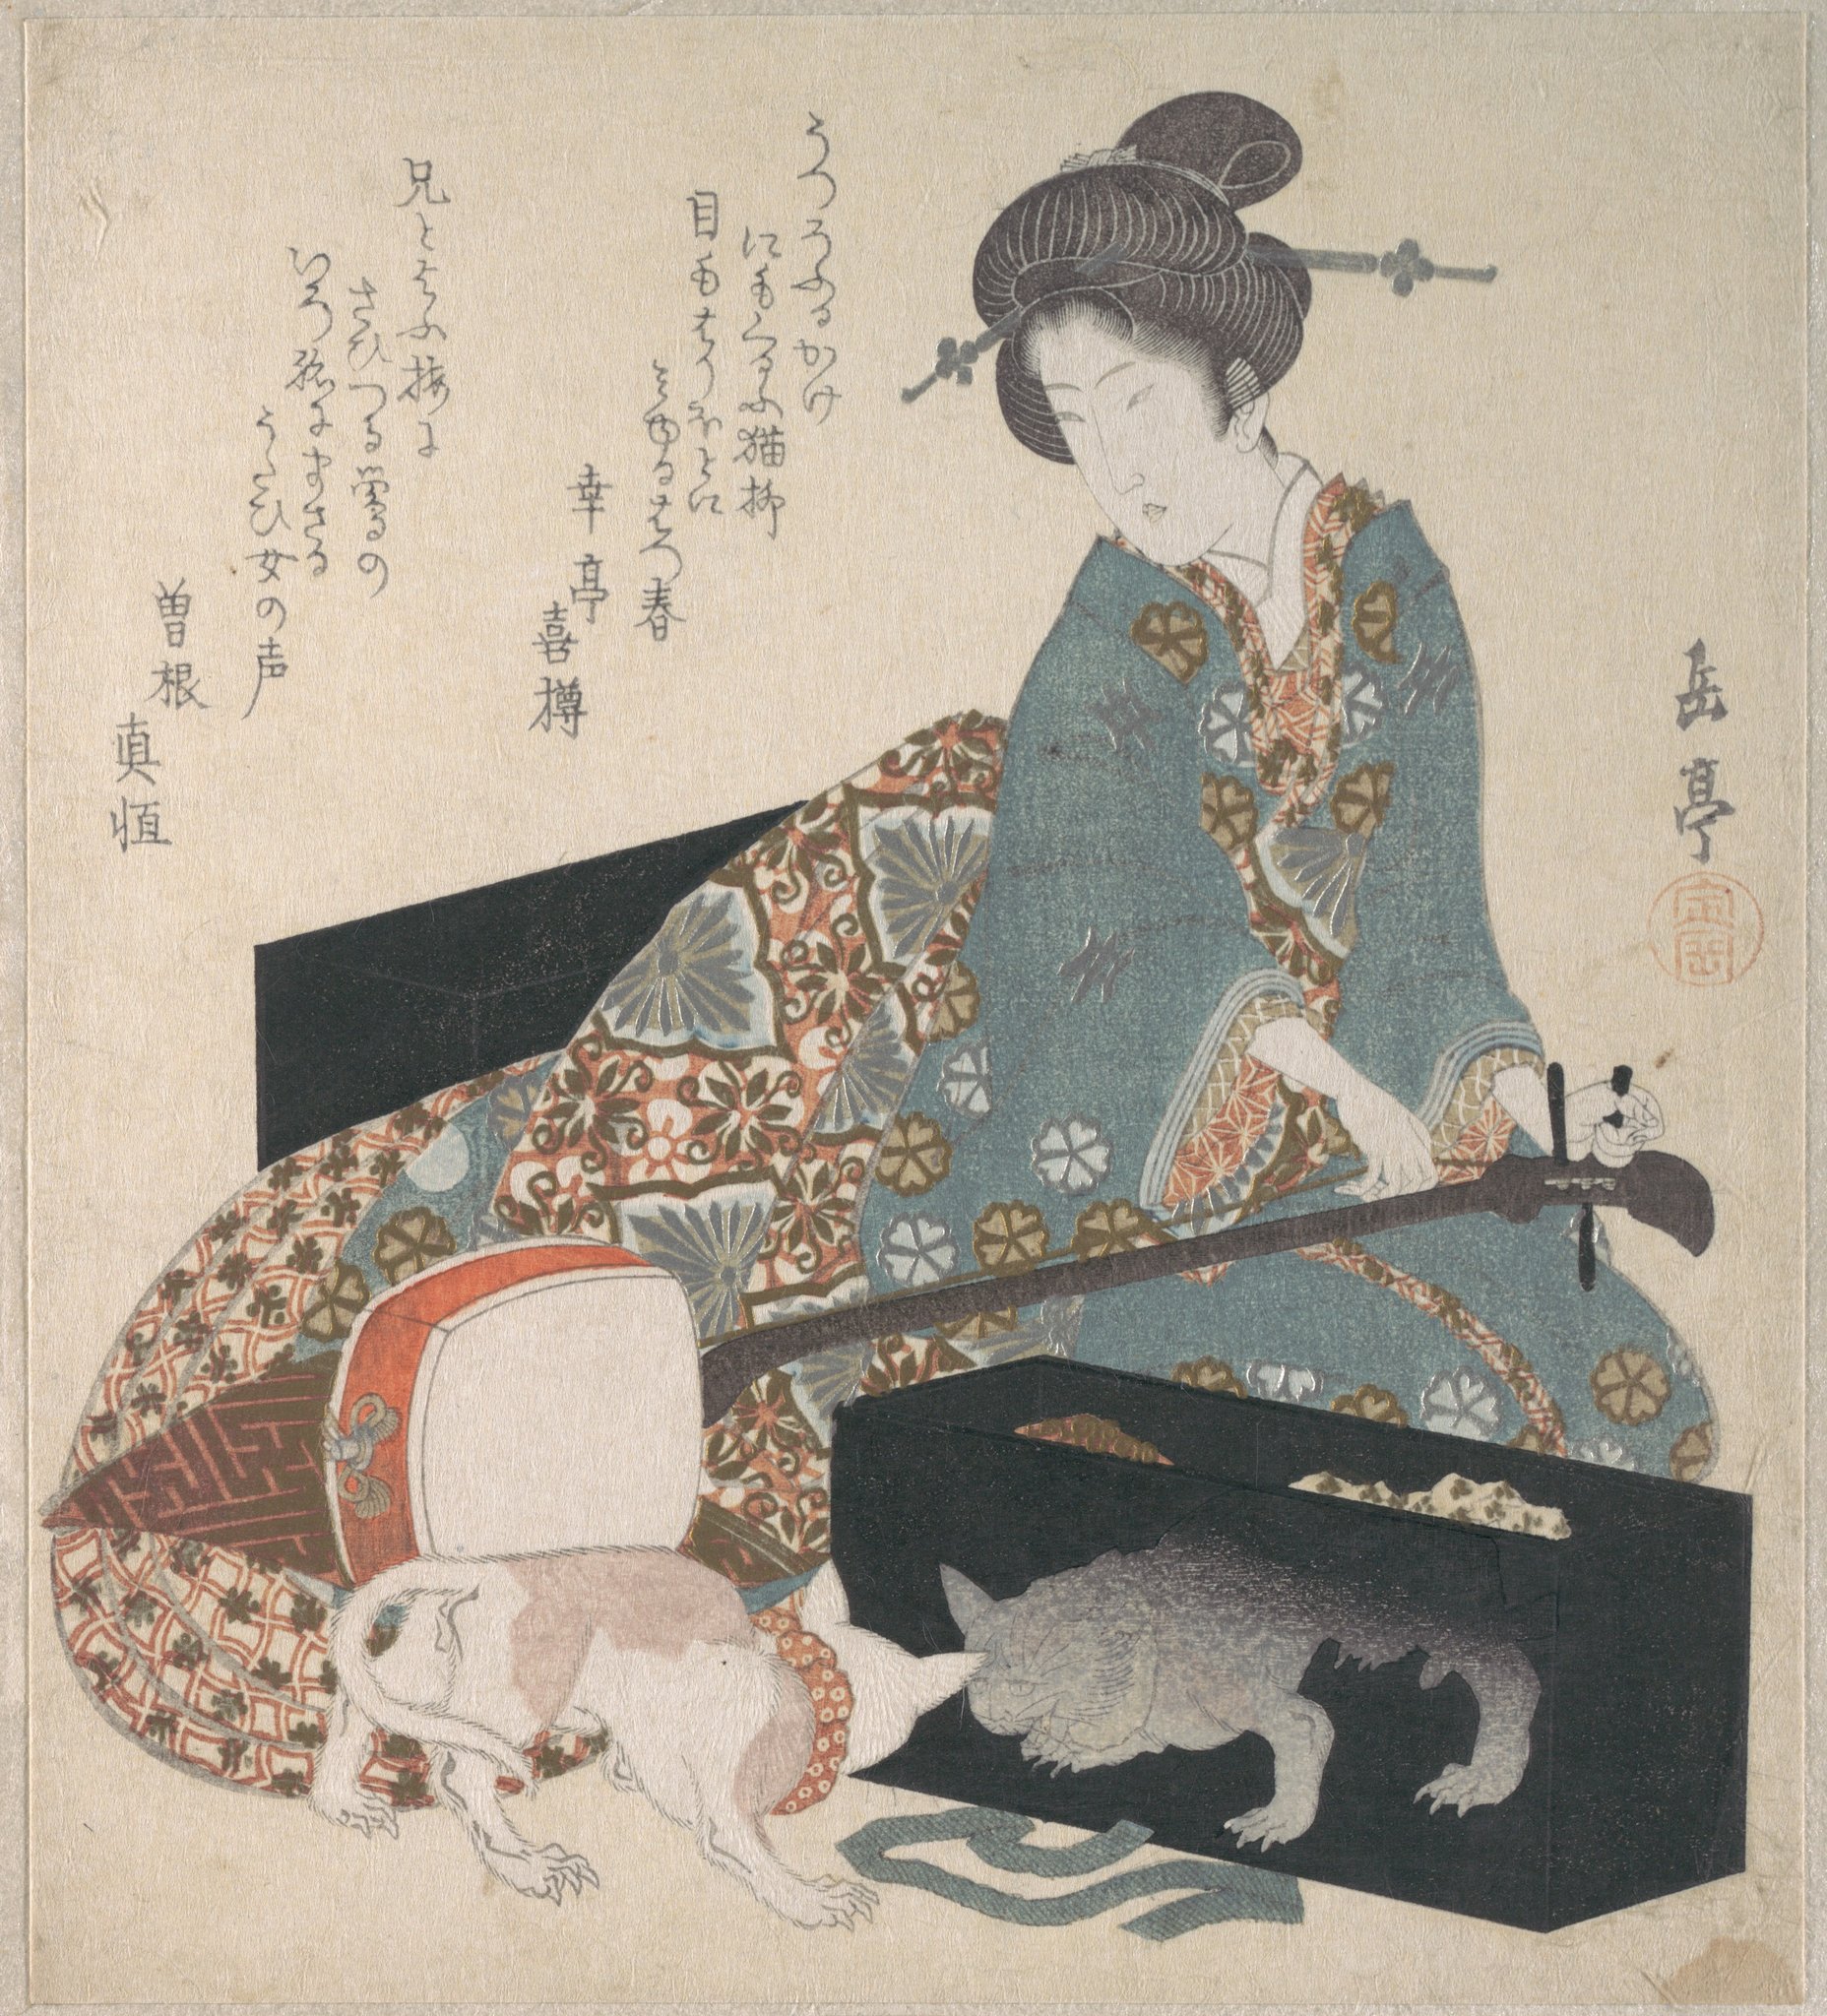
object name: print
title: Woman Tuning a Shamisen and a Cat Looking at its Own Reflection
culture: japanese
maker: yashima gakutei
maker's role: artist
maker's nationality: japanese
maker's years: 1786-1868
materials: ink, paper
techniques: surimono, woodblock print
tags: musical instruments,women,cats